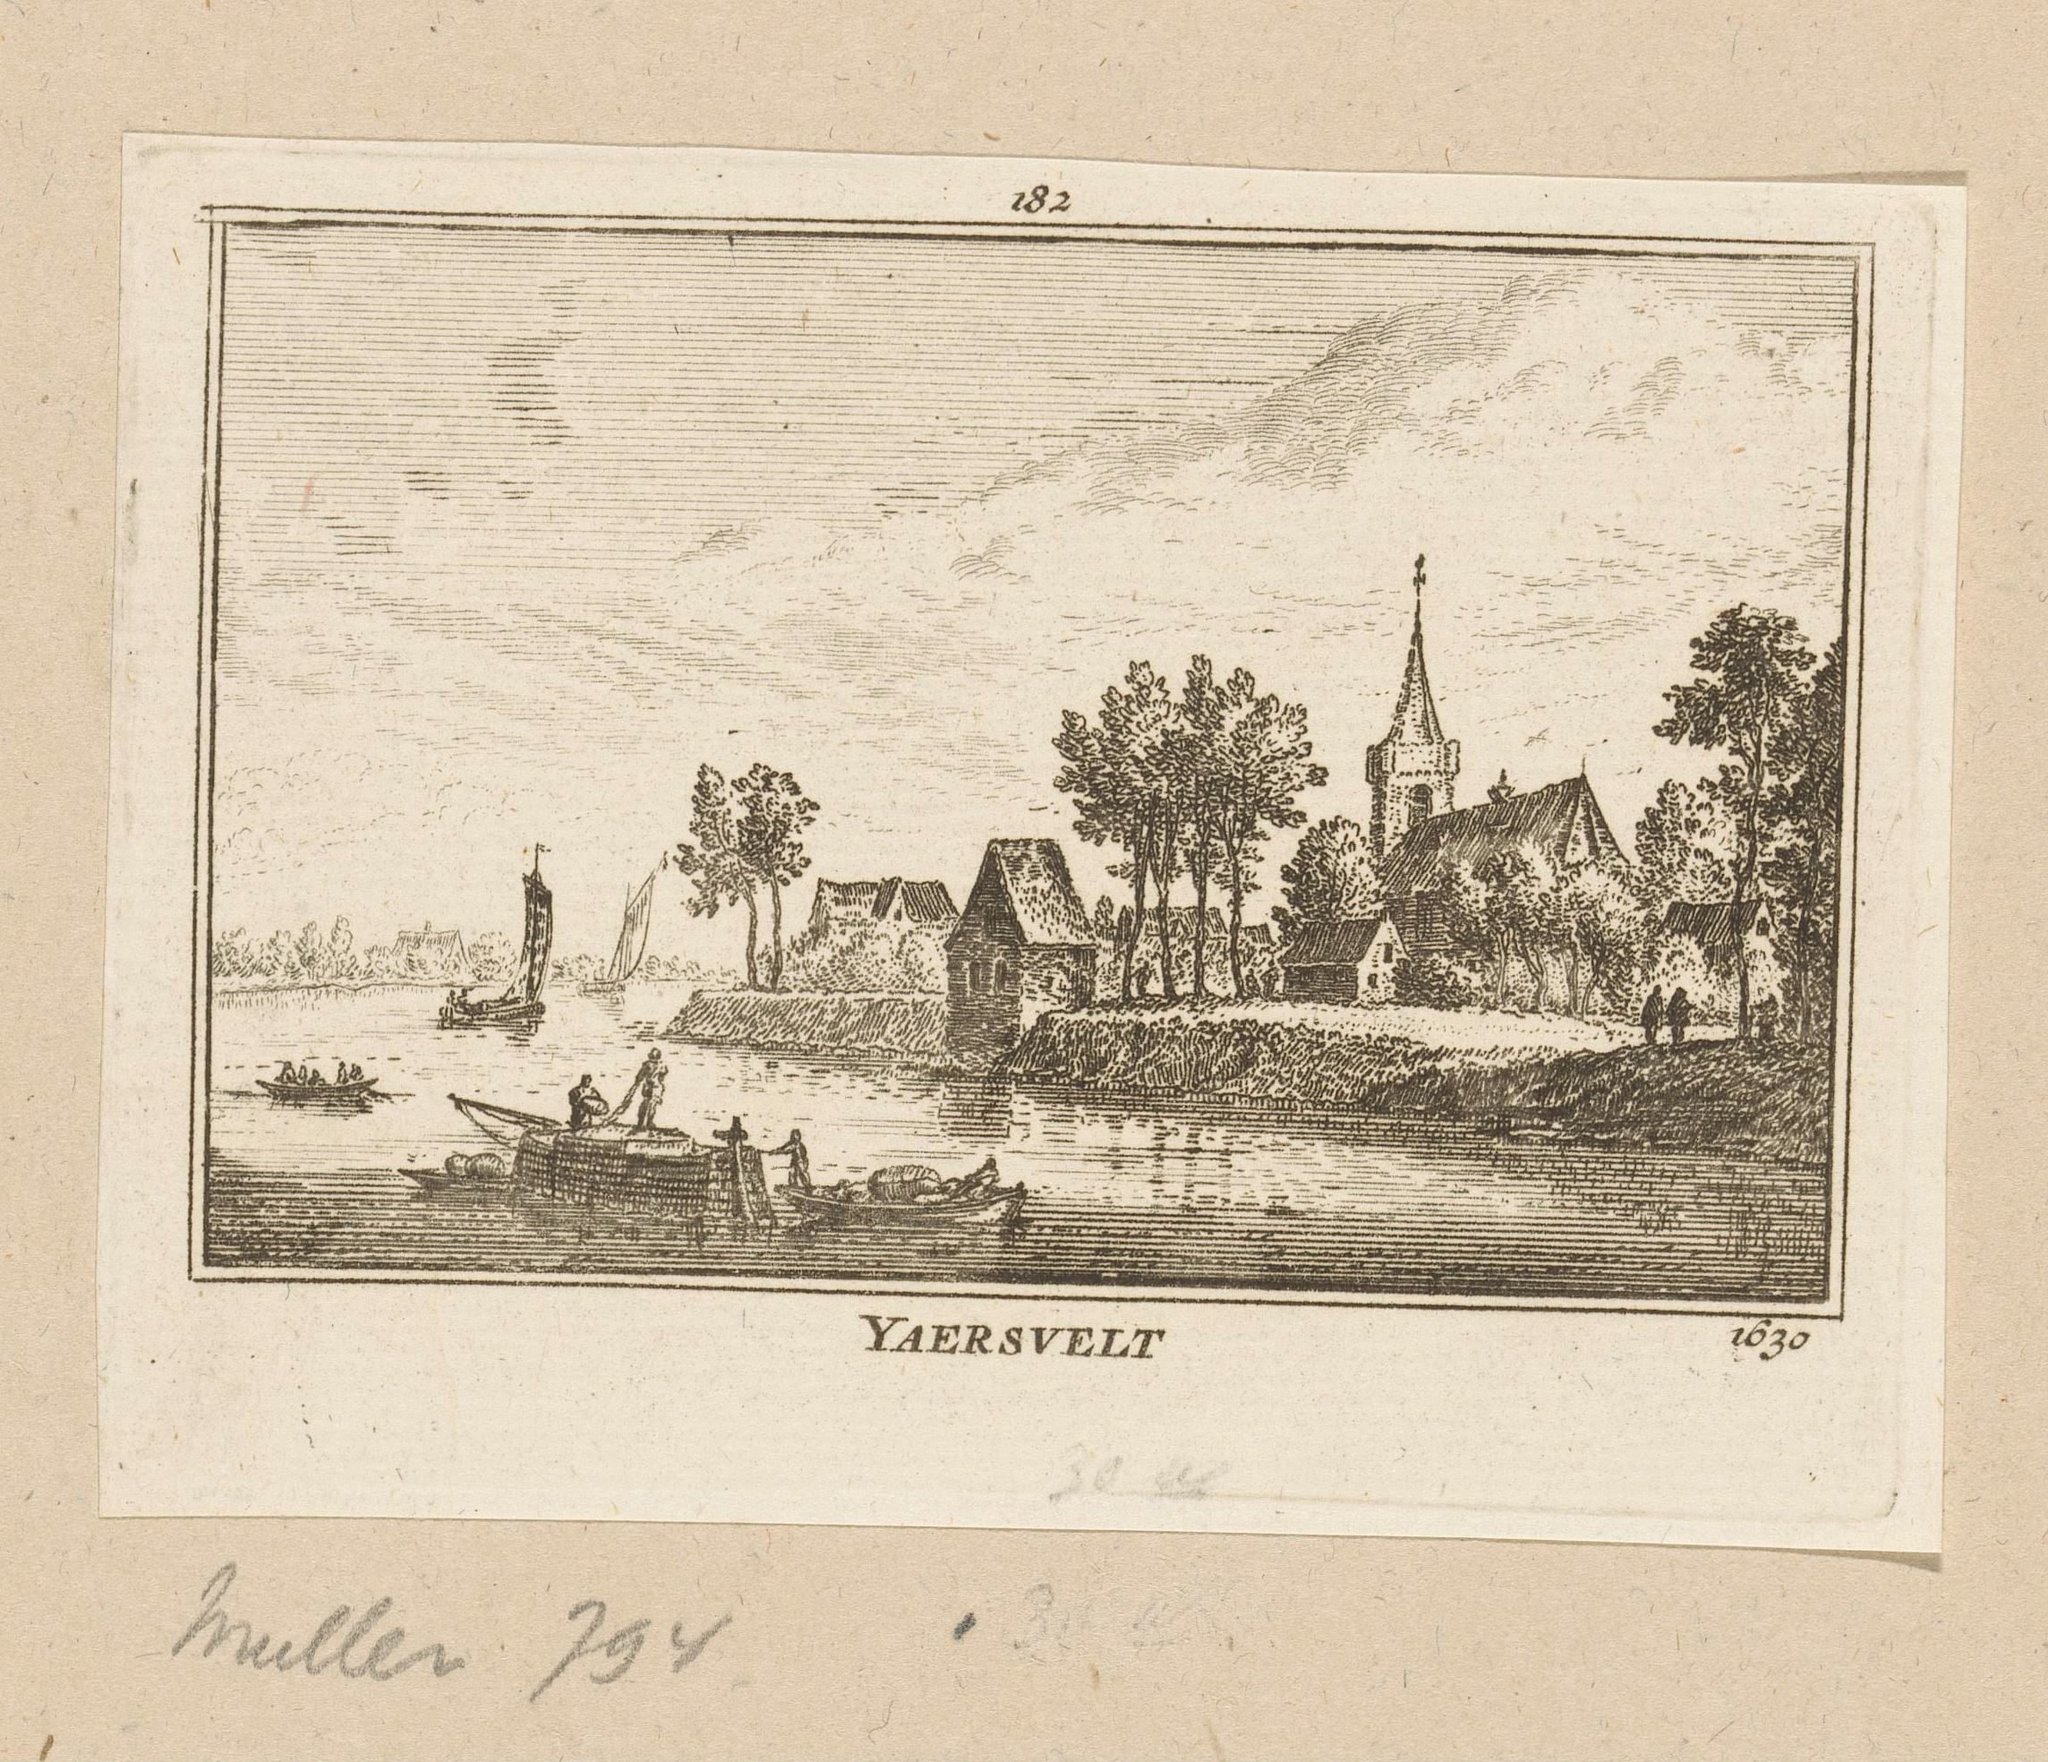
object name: book illustration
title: Gezicht op Jaarsveld, 1630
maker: abraham rademaker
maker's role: draughtsman, print maker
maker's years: 1676-1735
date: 1725-1803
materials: paper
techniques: engraving, etching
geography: amsterdam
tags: prospect of village, silhouette of village, sailing-ship, sailing-boat, church (exterior), rowing-boat, canoe, etc., jaarsveld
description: Prent ook gebruikt in: Rademaker, Abraham. Kabinet van Nederlandsche outheden en gezichten: vervat in 300 konstplaaten (…). 2 delen. Amsterdam: Willem Barents, 1725, dl. 2, ill. 182. Na 1725 is deze prent nog in verschillende heruitgaven verschenen, uitgegeven in 1727-1733, 1770-1771 en 1792-1803. Uit welke uitgave het huidige exemplaar precies komt is niet na te gaan.